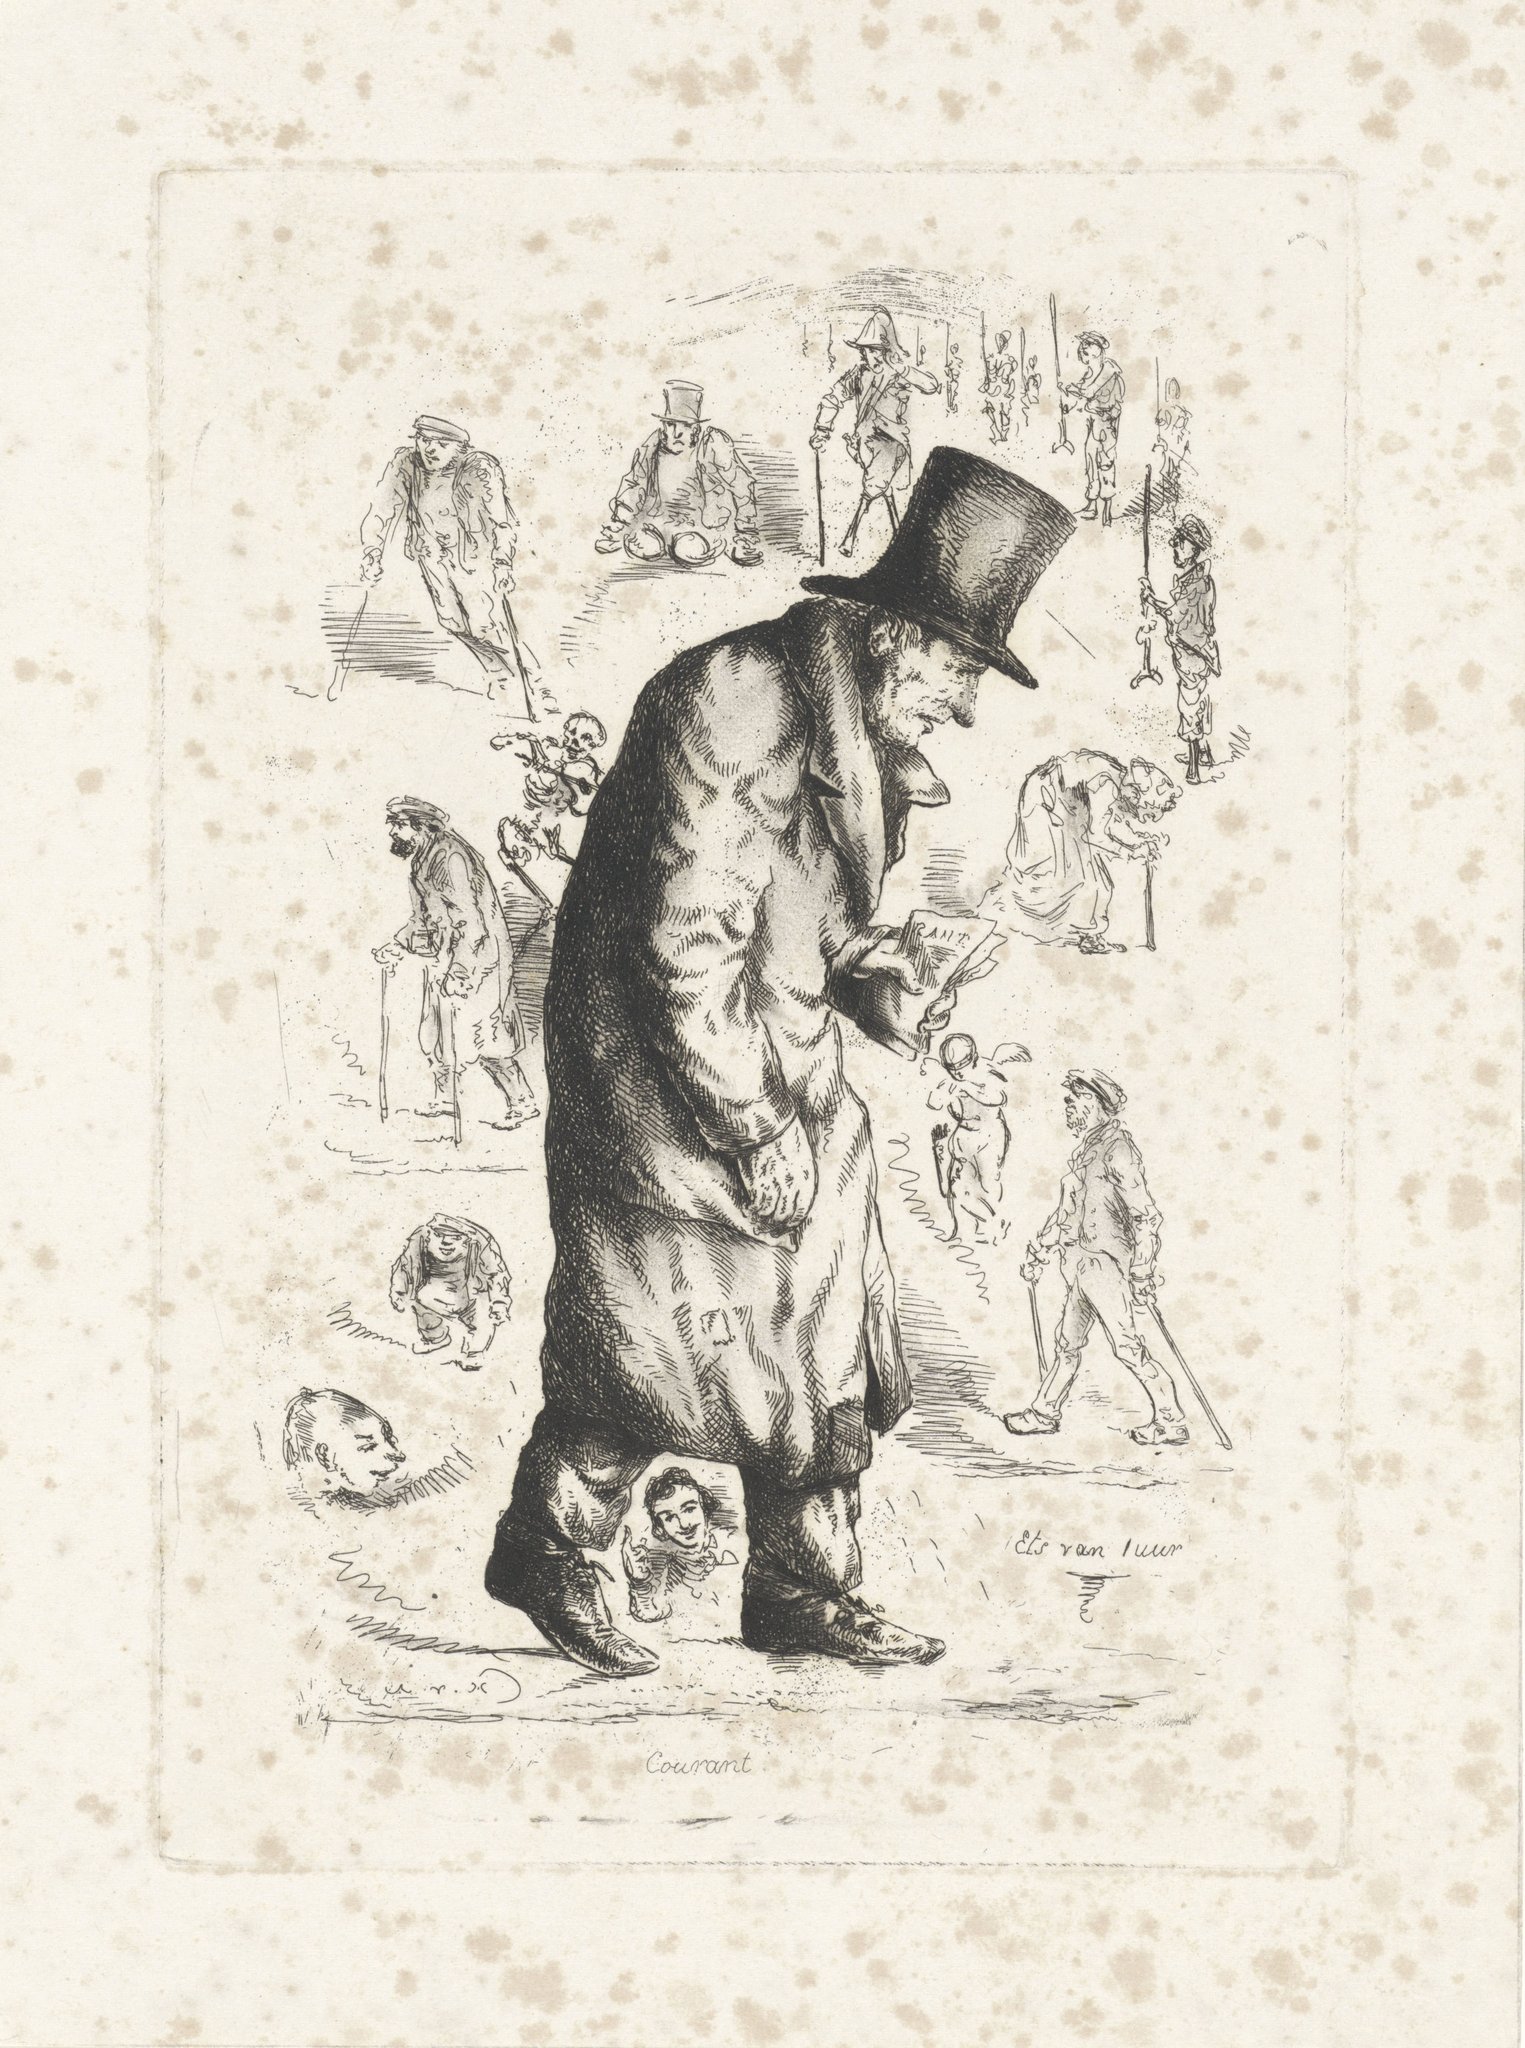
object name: print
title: Man met hoge hoed tegen en schetsen van mensen met verschillende lichamelijke beperkingen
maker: alexander ver huell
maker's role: draughtsman, print maker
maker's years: 1822-1897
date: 1832-1897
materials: paper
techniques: etching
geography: netherlands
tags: crutches, wooden leg, head-gear: hat (+ men's clothes), newspaper, news-sheet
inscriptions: collector's mark: Lugt 2228, inscription: ‘Ets van 1 uur’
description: Een man met een versleten jas aan en een hoge hoed op het hoofd heeft een krant in zijn hand en loopt licht gebogen naar rechts. Op de achtergrond verschillende figuren op krukken en soldaten met houten benen. Tussen deze figuren ook de Dood spelend op een viool.